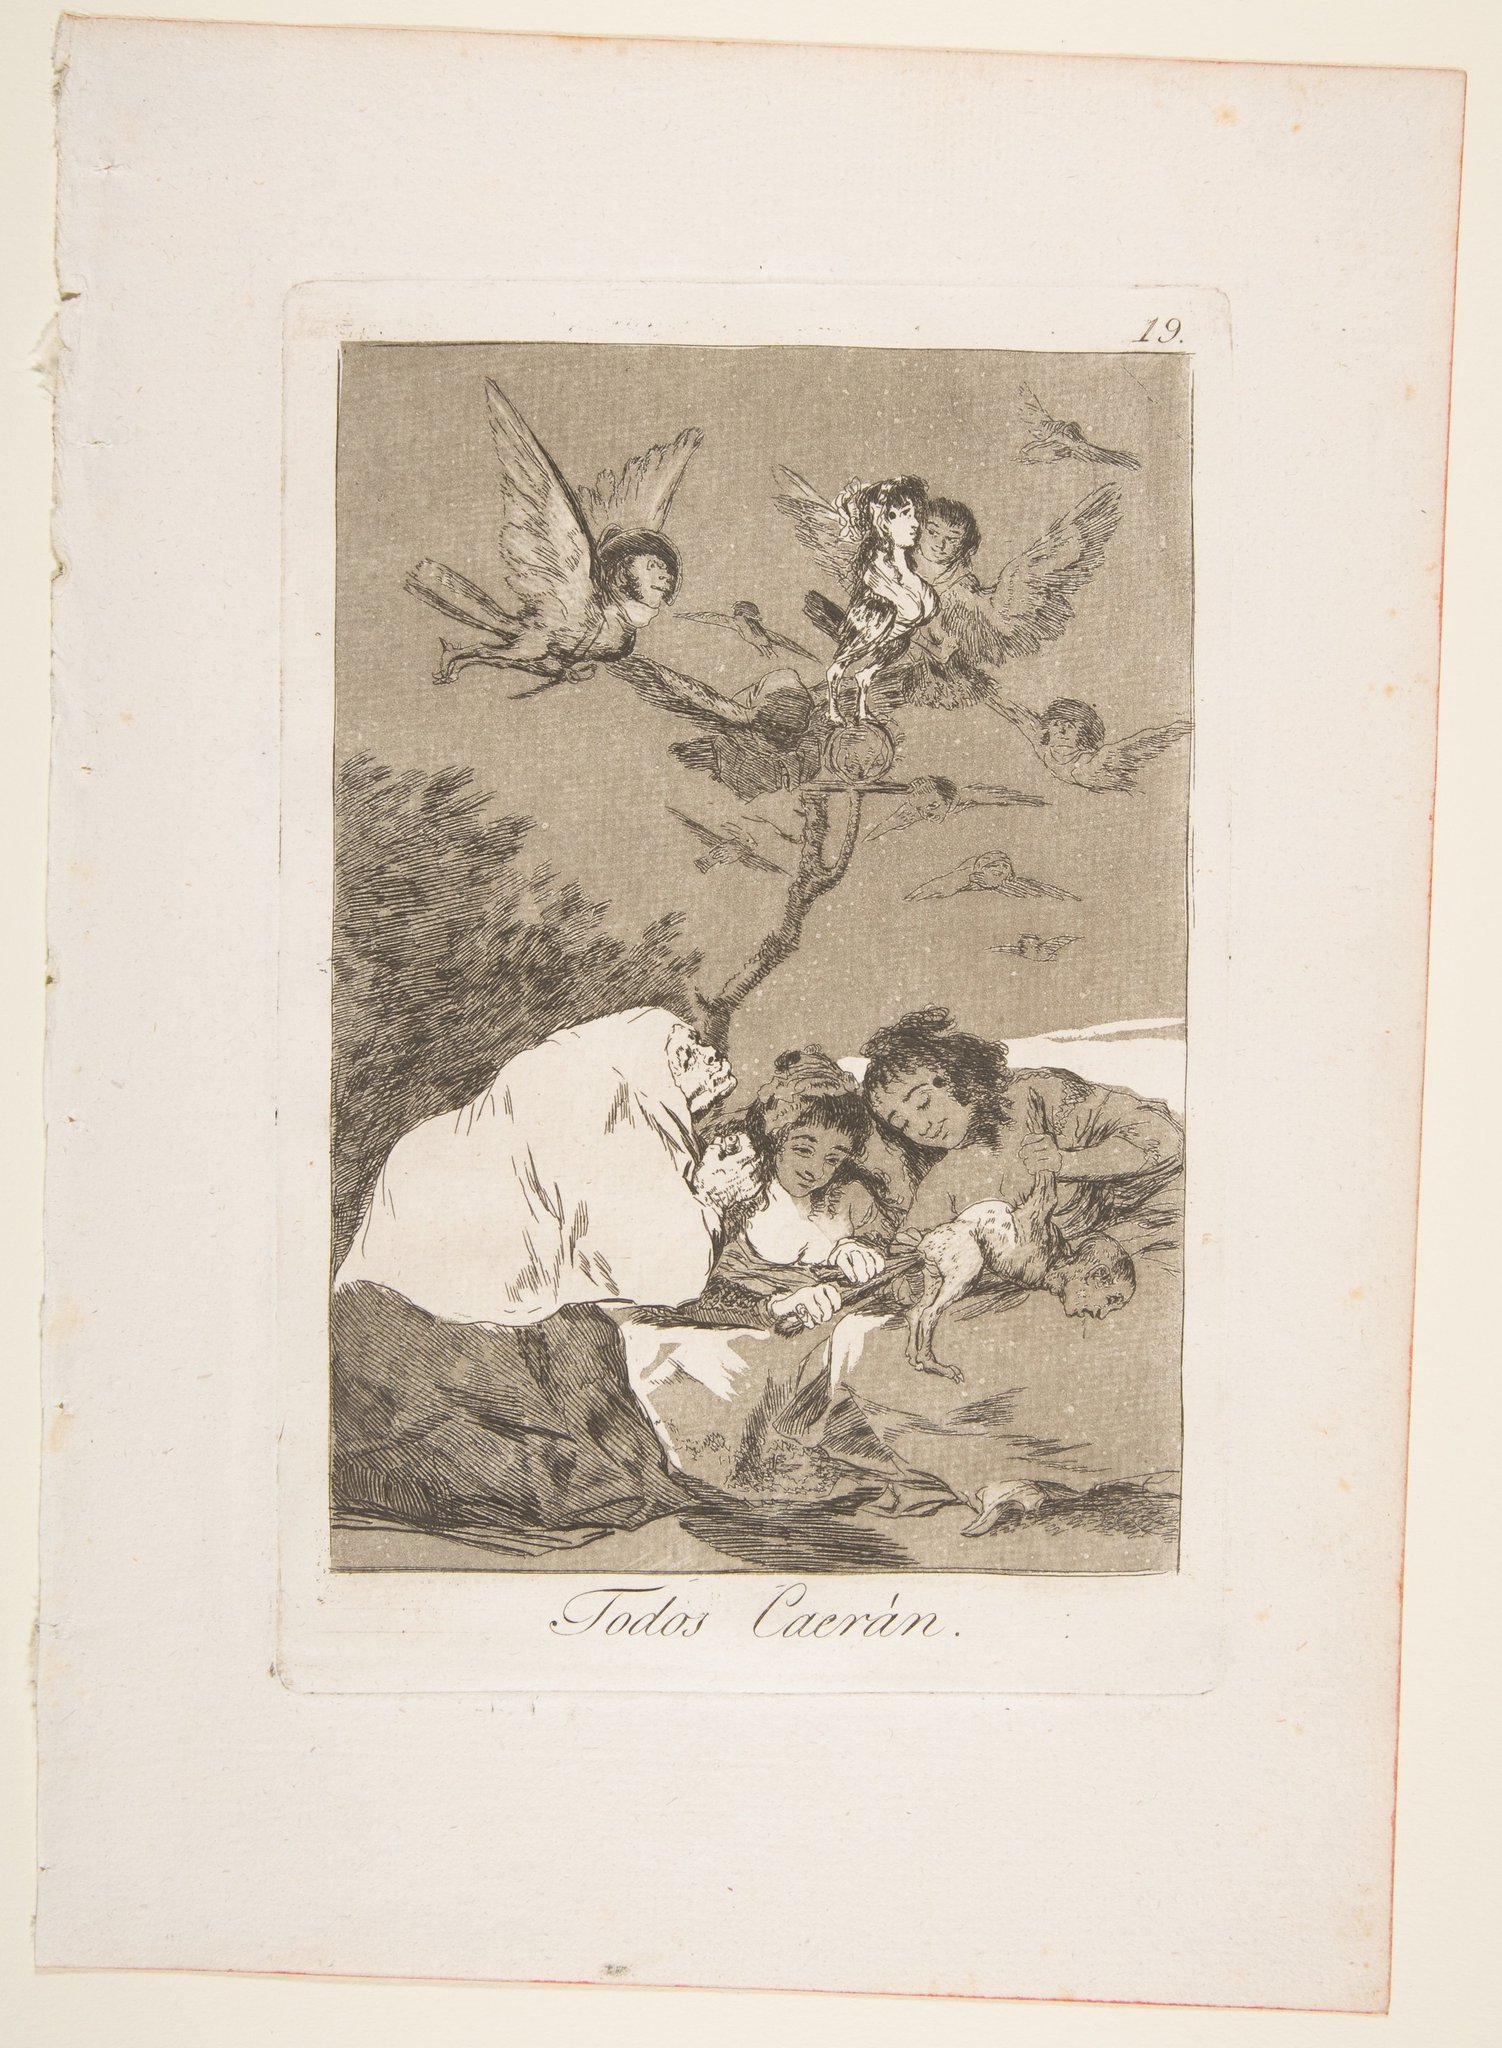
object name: print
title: Plate 19 from "Los Caprichos": All will fall (Todos Caerán)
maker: goya (francisco de goya y lucientes)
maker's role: artist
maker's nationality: spanish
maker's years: 1746-1828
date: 1799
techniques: aquatint, burnishing, etching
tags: satire,women